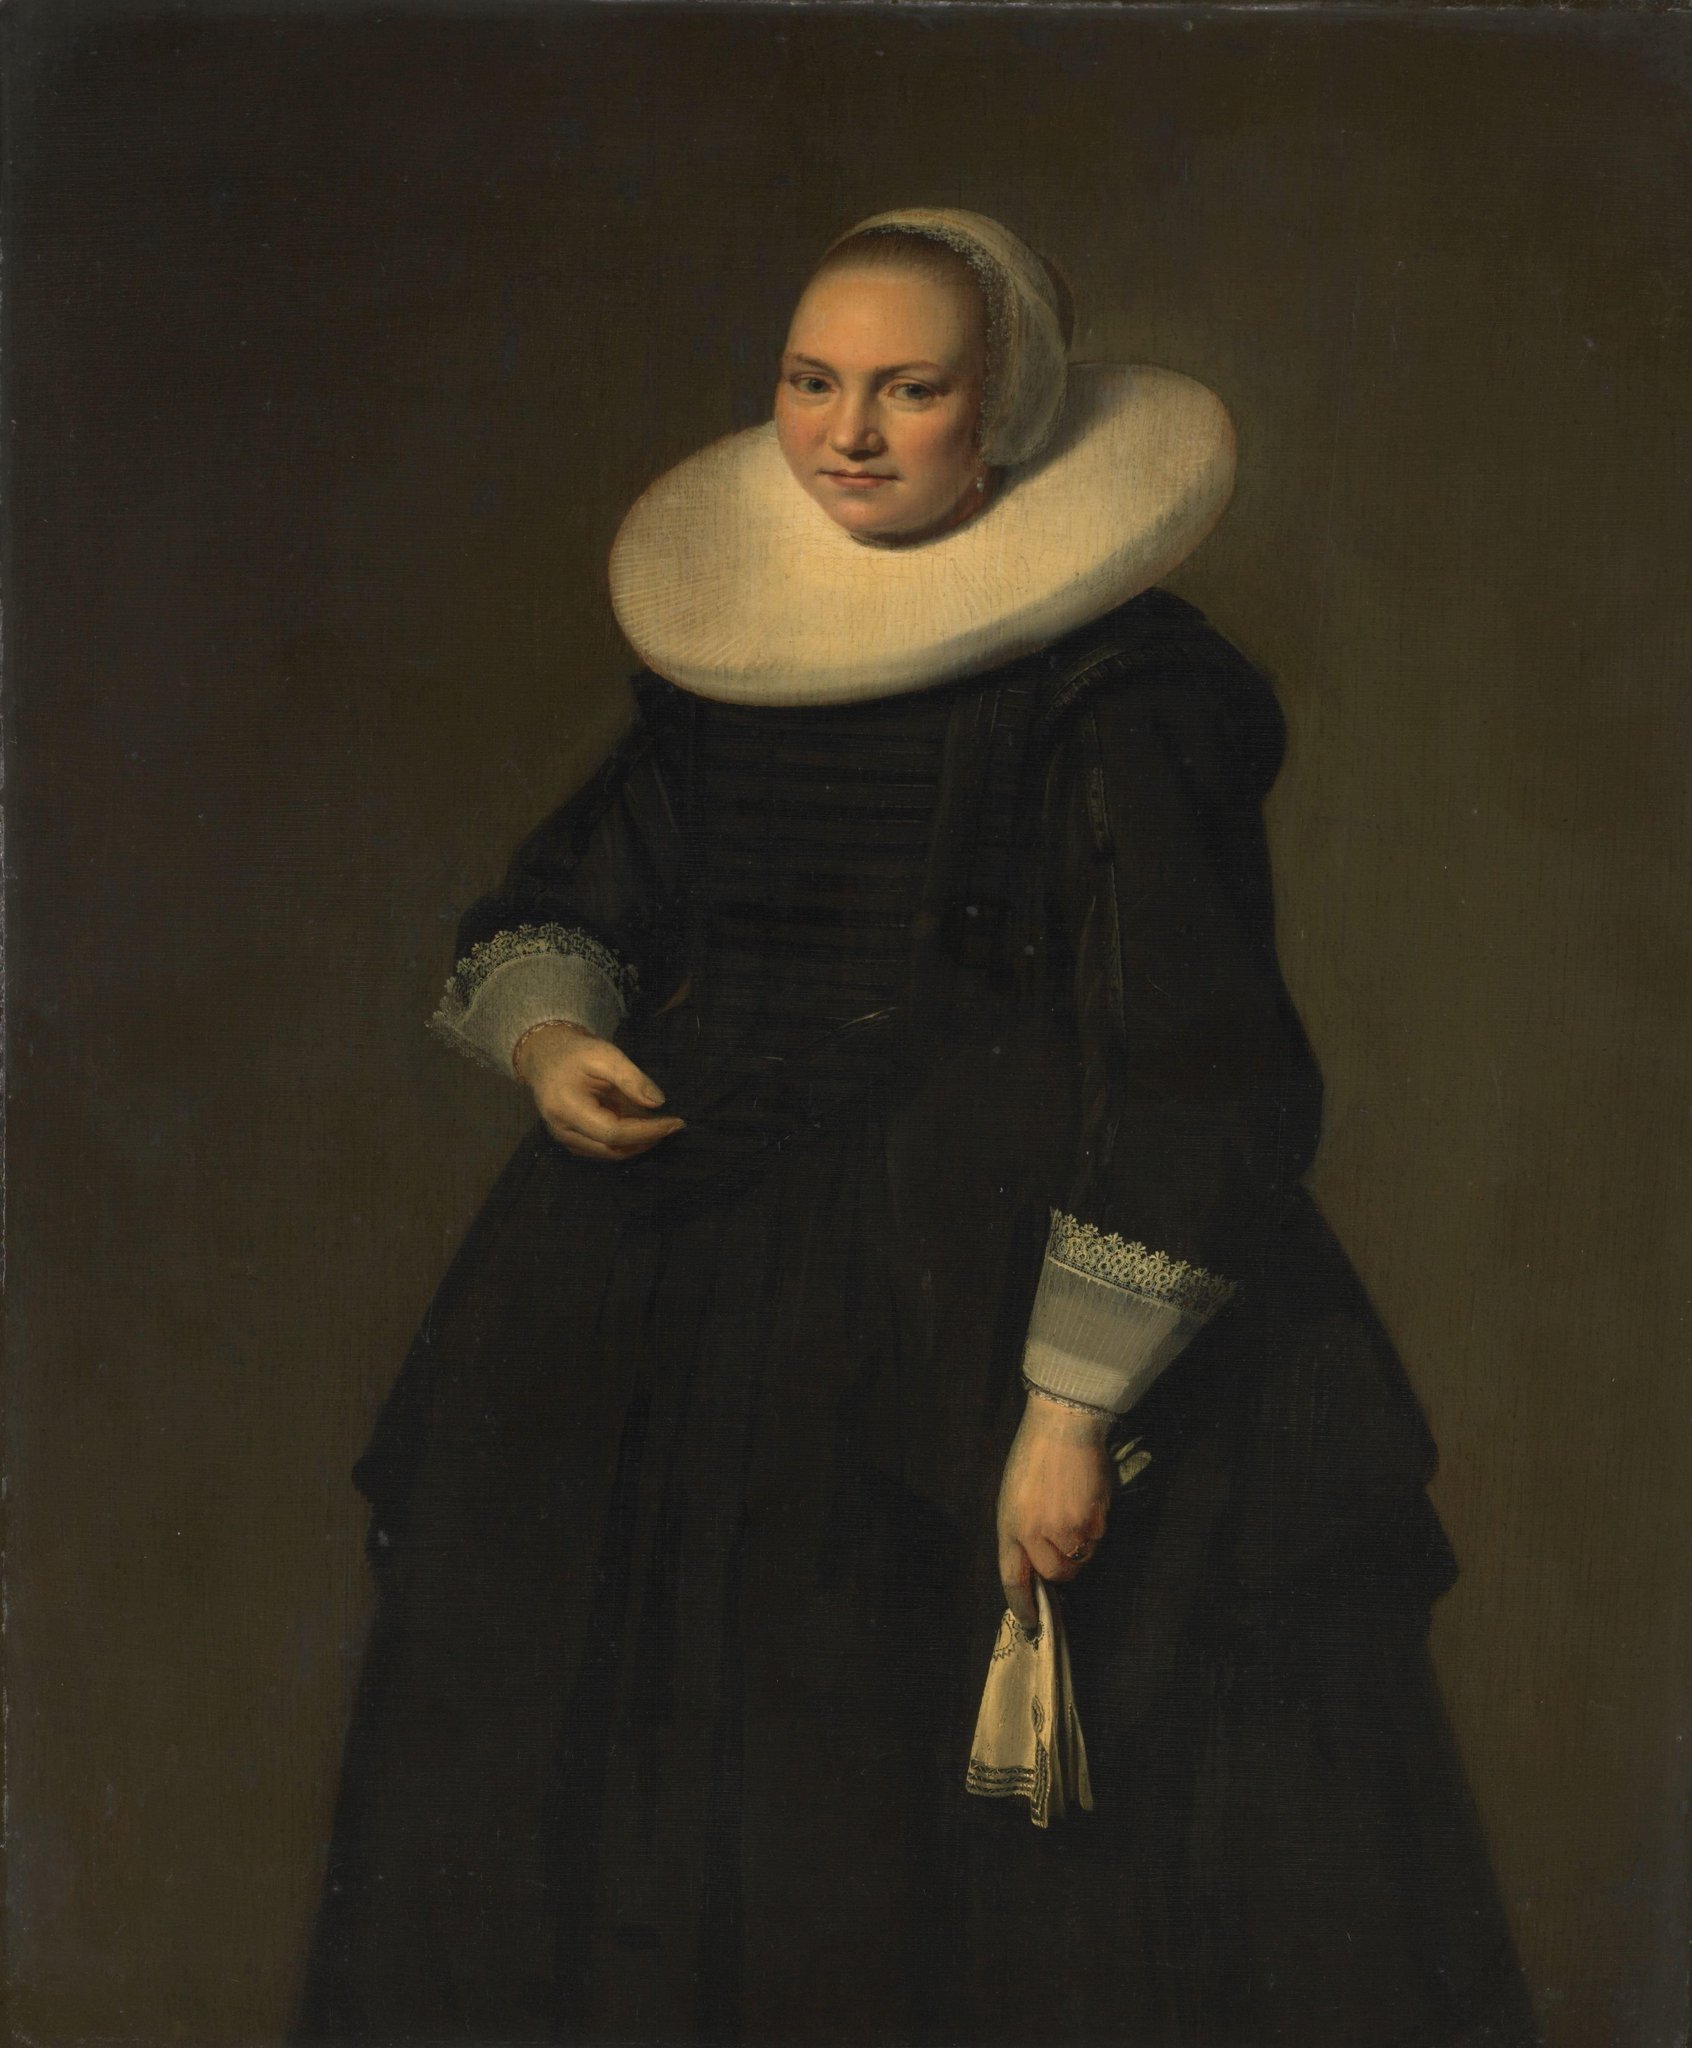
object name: painting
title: Portrait of a Woman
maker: hendrik gerritsz pot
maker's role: draughtsman, painter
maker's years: 1580-1657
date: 1638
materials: oil, panel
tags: anonymous historical person portrayed - bb - woman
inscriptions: inscription and date, top right: ‘Ætatis 3[.] / Anno 1638’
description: Portret van een vrouw. Staande, bijna ten voeten uit, iets naar links, het gelaat en face. Handschoenen in de linkerhand, de rechterhand voor de buik.